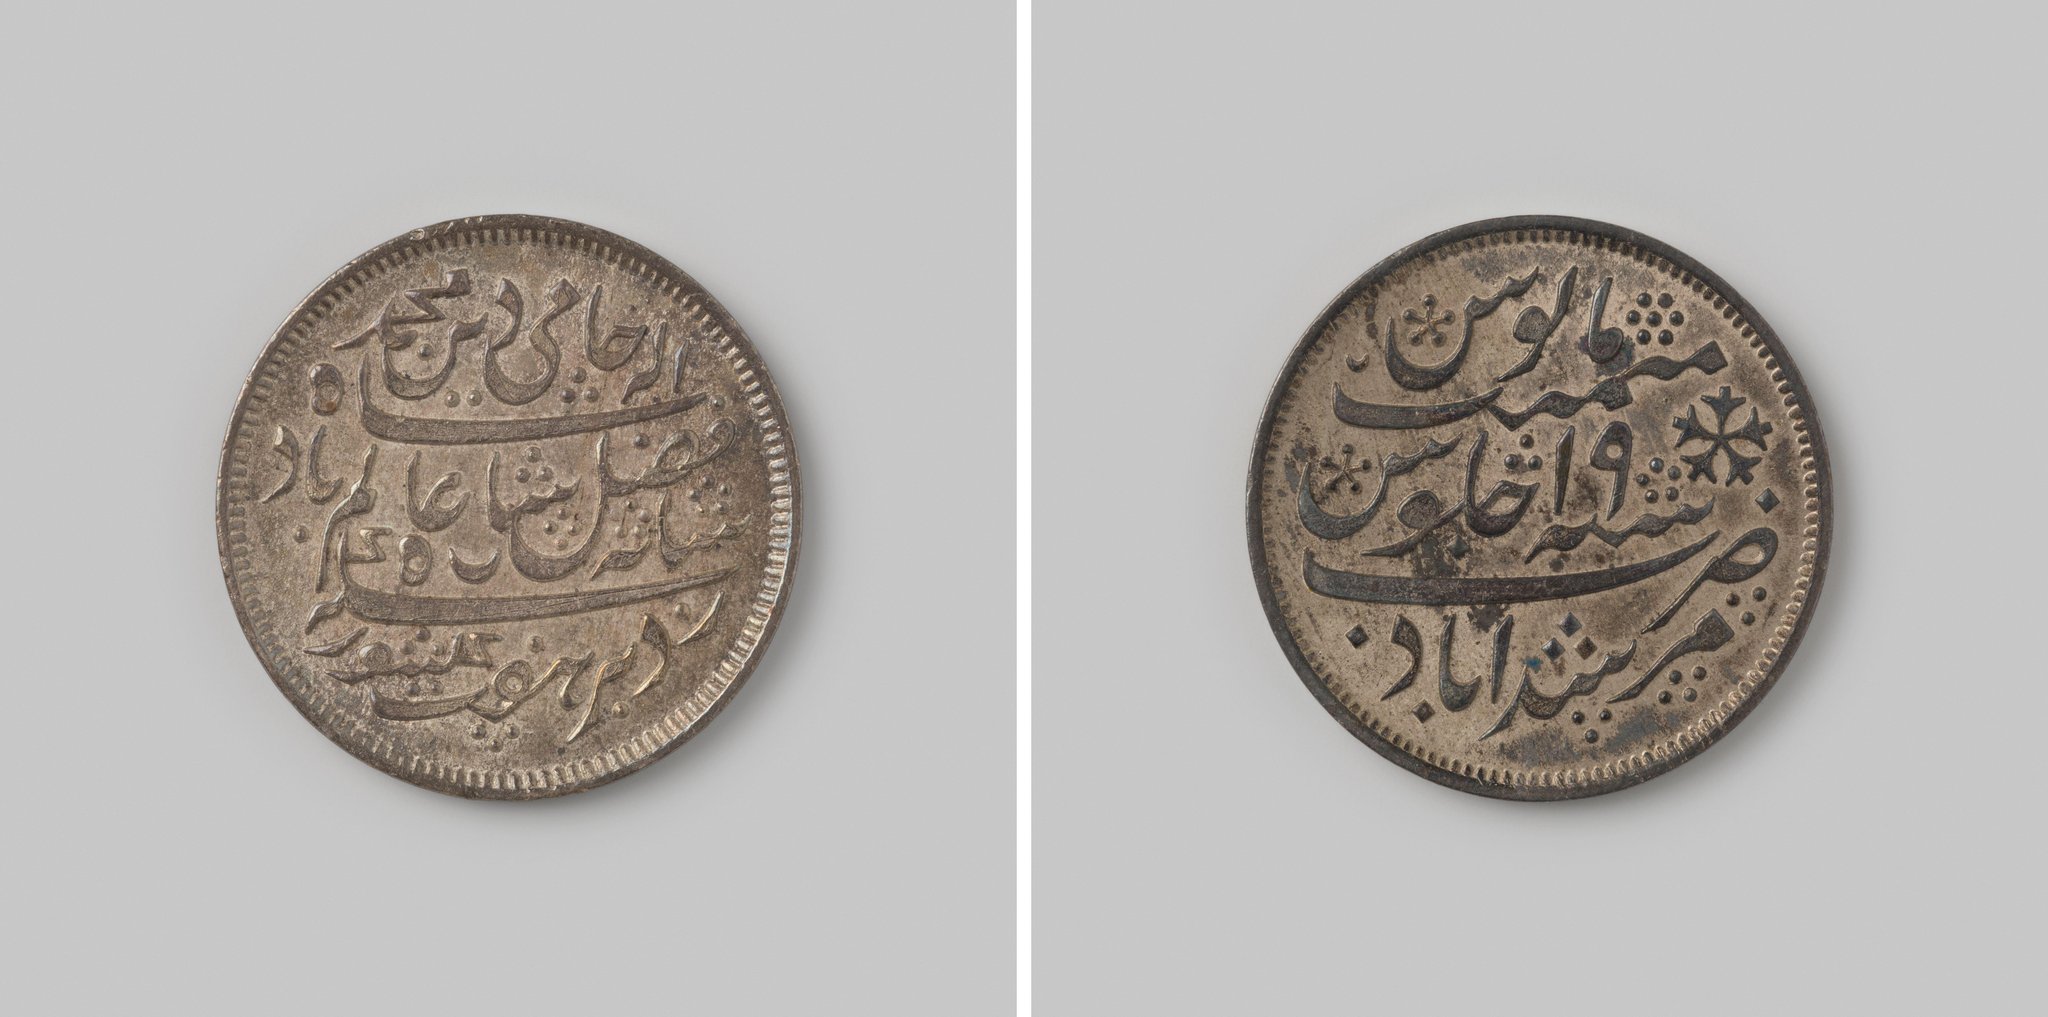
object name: coin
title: ½ roepie uit Bengalen in India van de Engelse Oostindische Compagnie (EIC) op naam van Sjah Alam I, regeringsjaar 19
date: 1830-1833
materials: silver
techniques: striking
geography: kolkata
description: Zilveren munt. Voorzijde: in Arabische lettertekens in drie regels opschrift. Keerzijde: in Arabische lettertekens in drie regels opschrift. Boven tweede regel aanduiding van het "eeuwige" regeringsjaar: 19. Gladde rand.